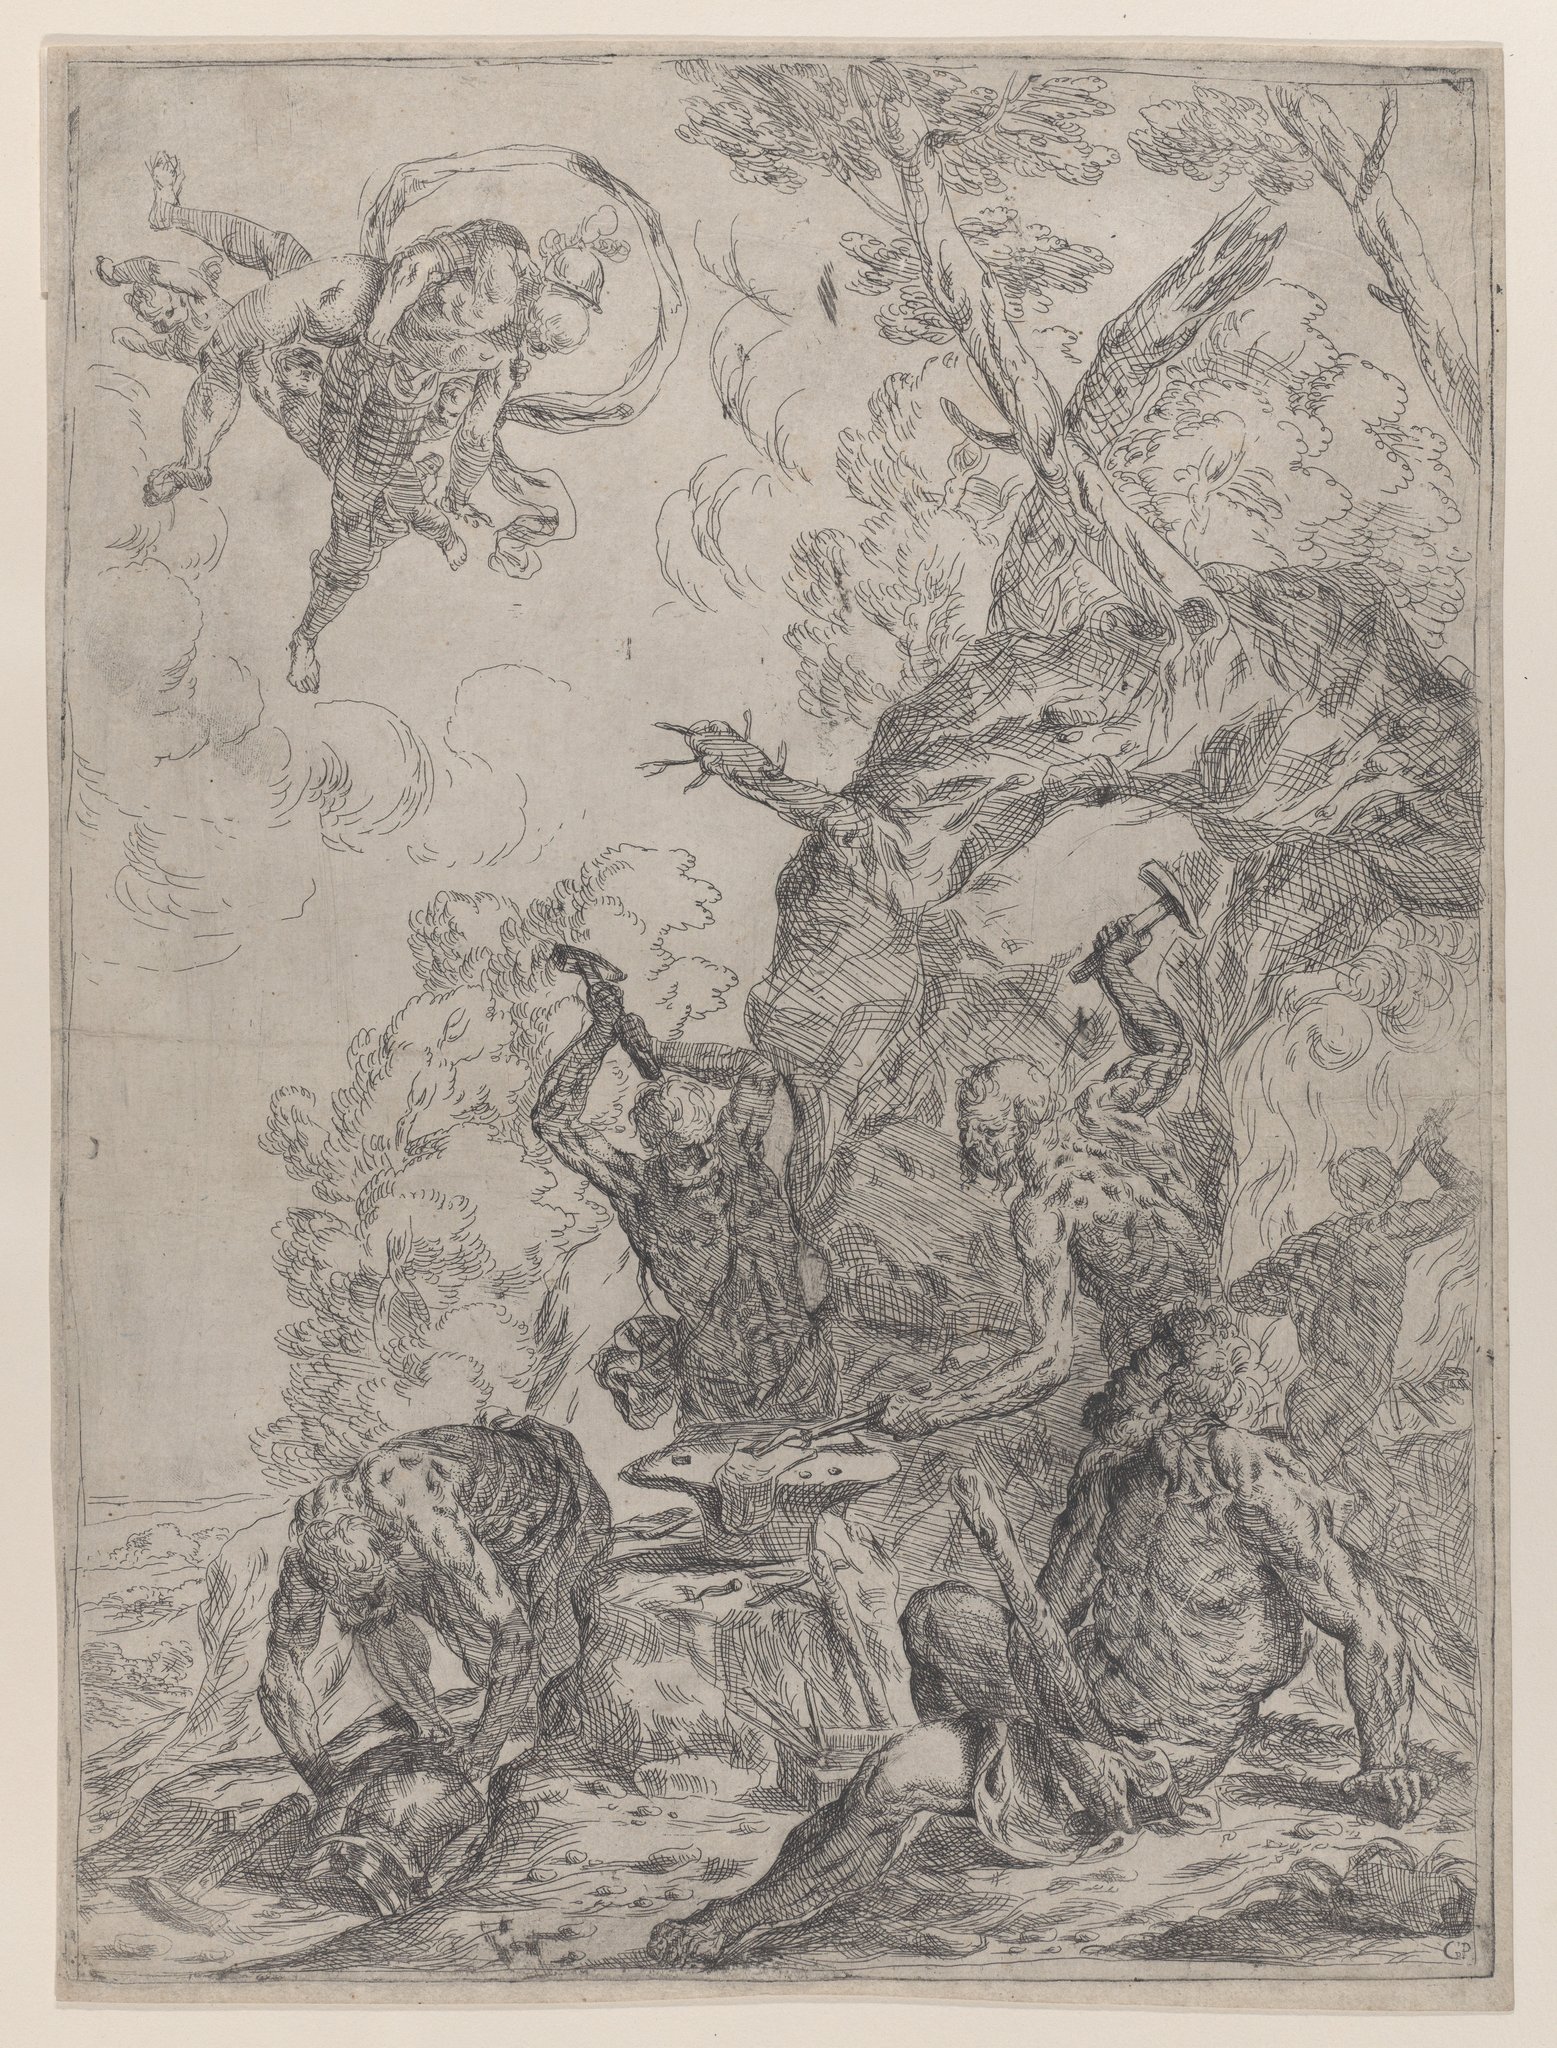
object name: print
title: The forge of Vulcan with smiths striking an anvil with hammers, while Mars and Venus embrace in the heavens above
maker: giovanni pietro possenti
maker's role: artist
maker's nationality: italian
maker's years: 1618-1659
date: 1640-1659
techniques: etching